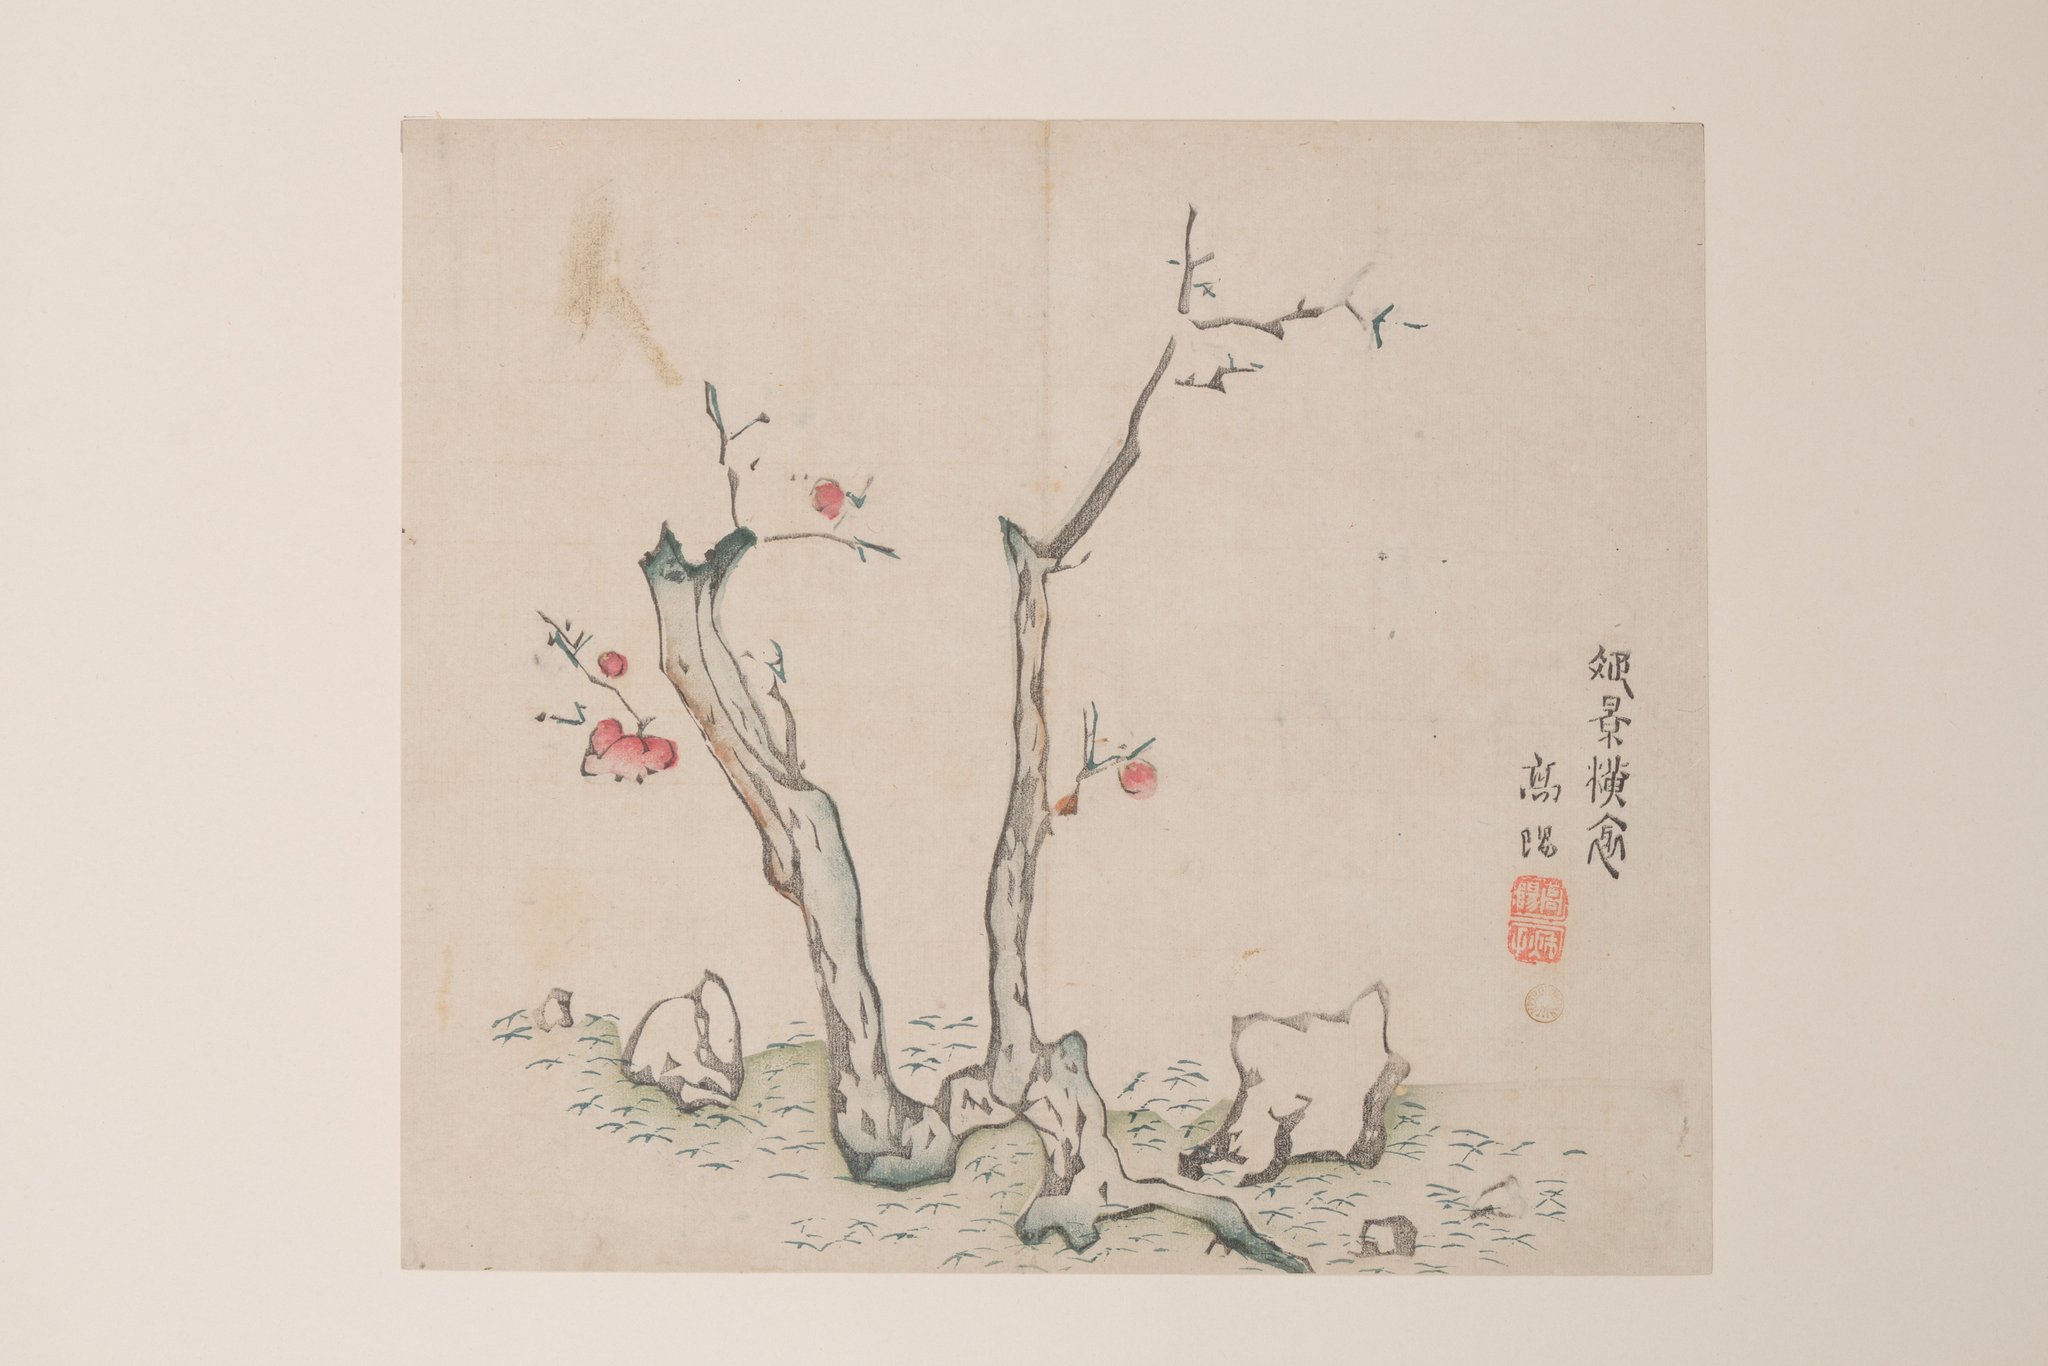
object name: print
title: Page from Shi Zhu Zhai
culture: chinese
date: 1662-1722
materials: ink, paper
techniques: polychrome, woodblock print